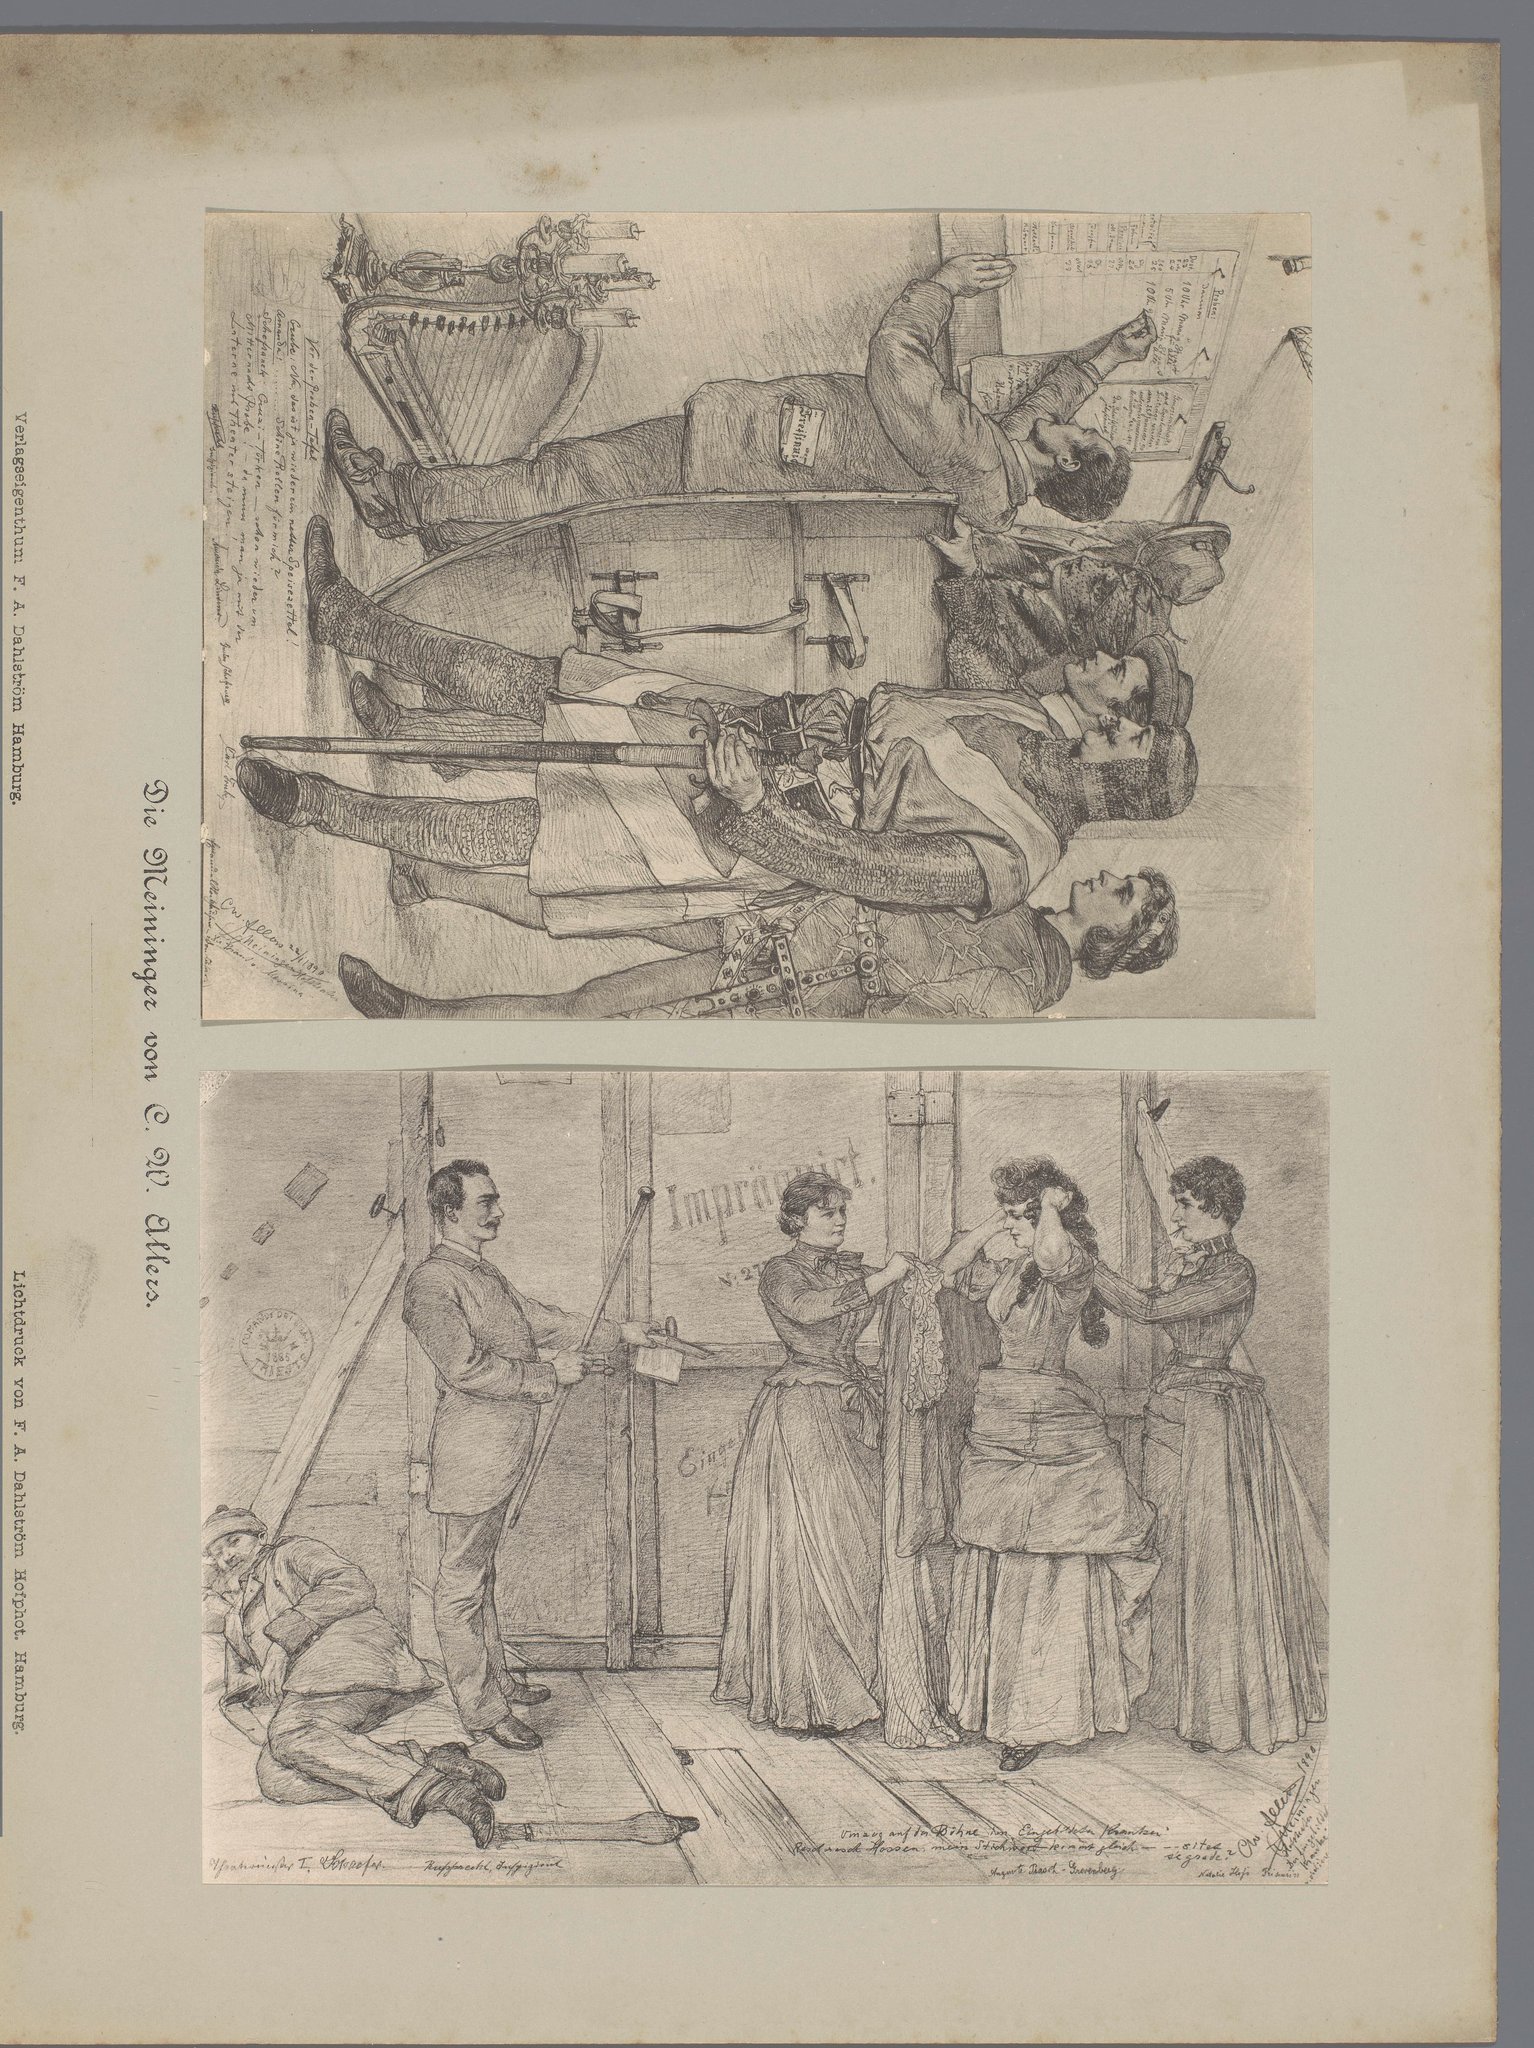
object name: page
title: Die Meininger von C. W. Allers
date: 1890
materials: paper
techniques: photograph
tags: dressing-room ~ stage, rehearsal, studying the role ~ theatre, portrait of actor, actress